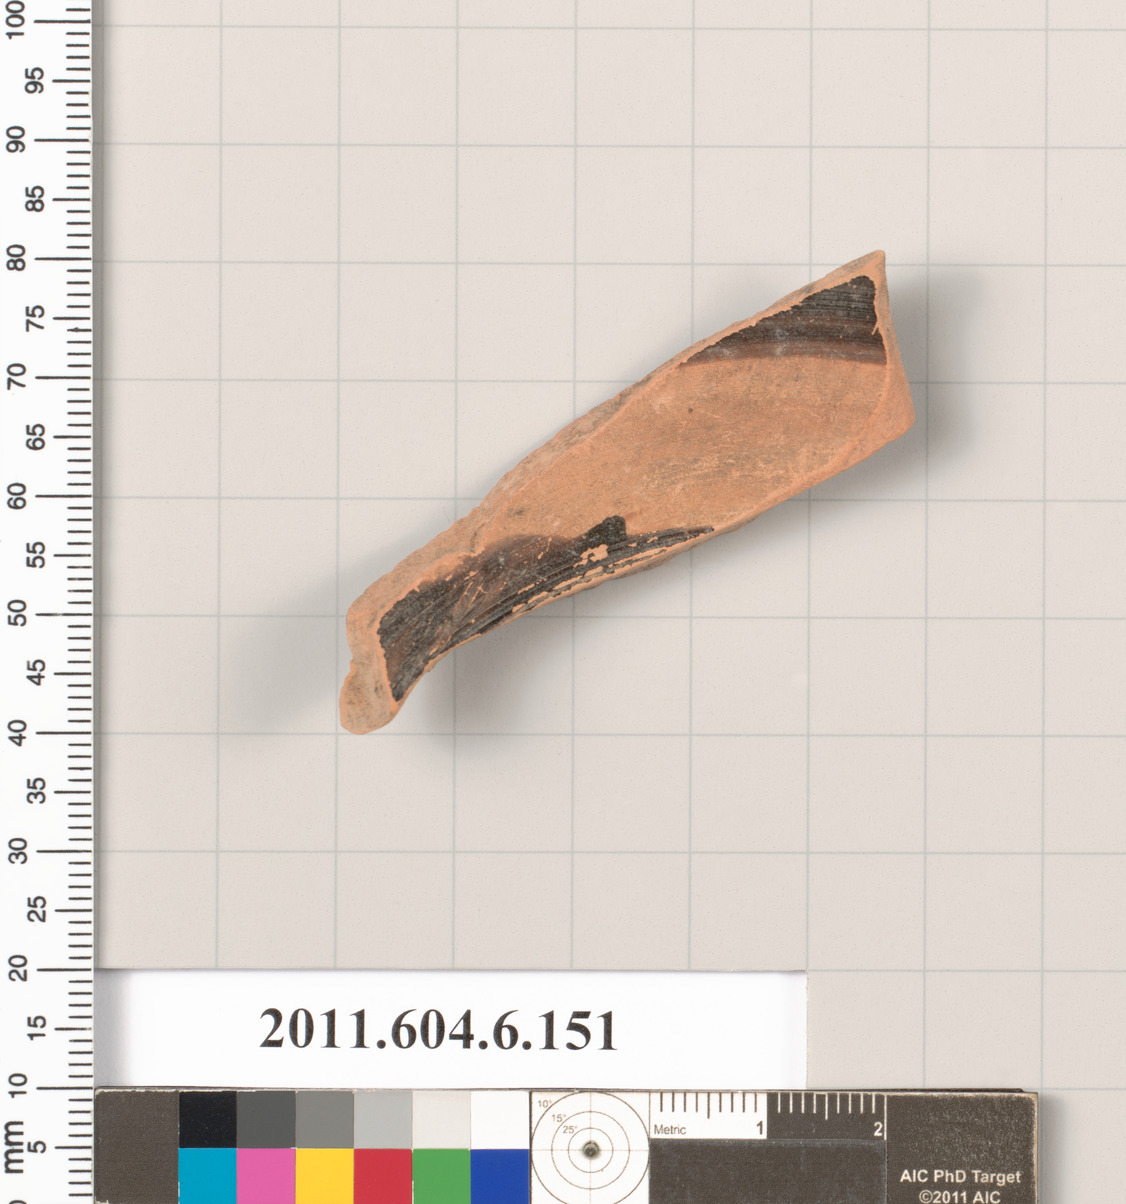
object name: undetermined shape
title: Terracotta fragment of an undetermined shape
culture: greek, attic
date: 600-401 BCE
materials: terracotta